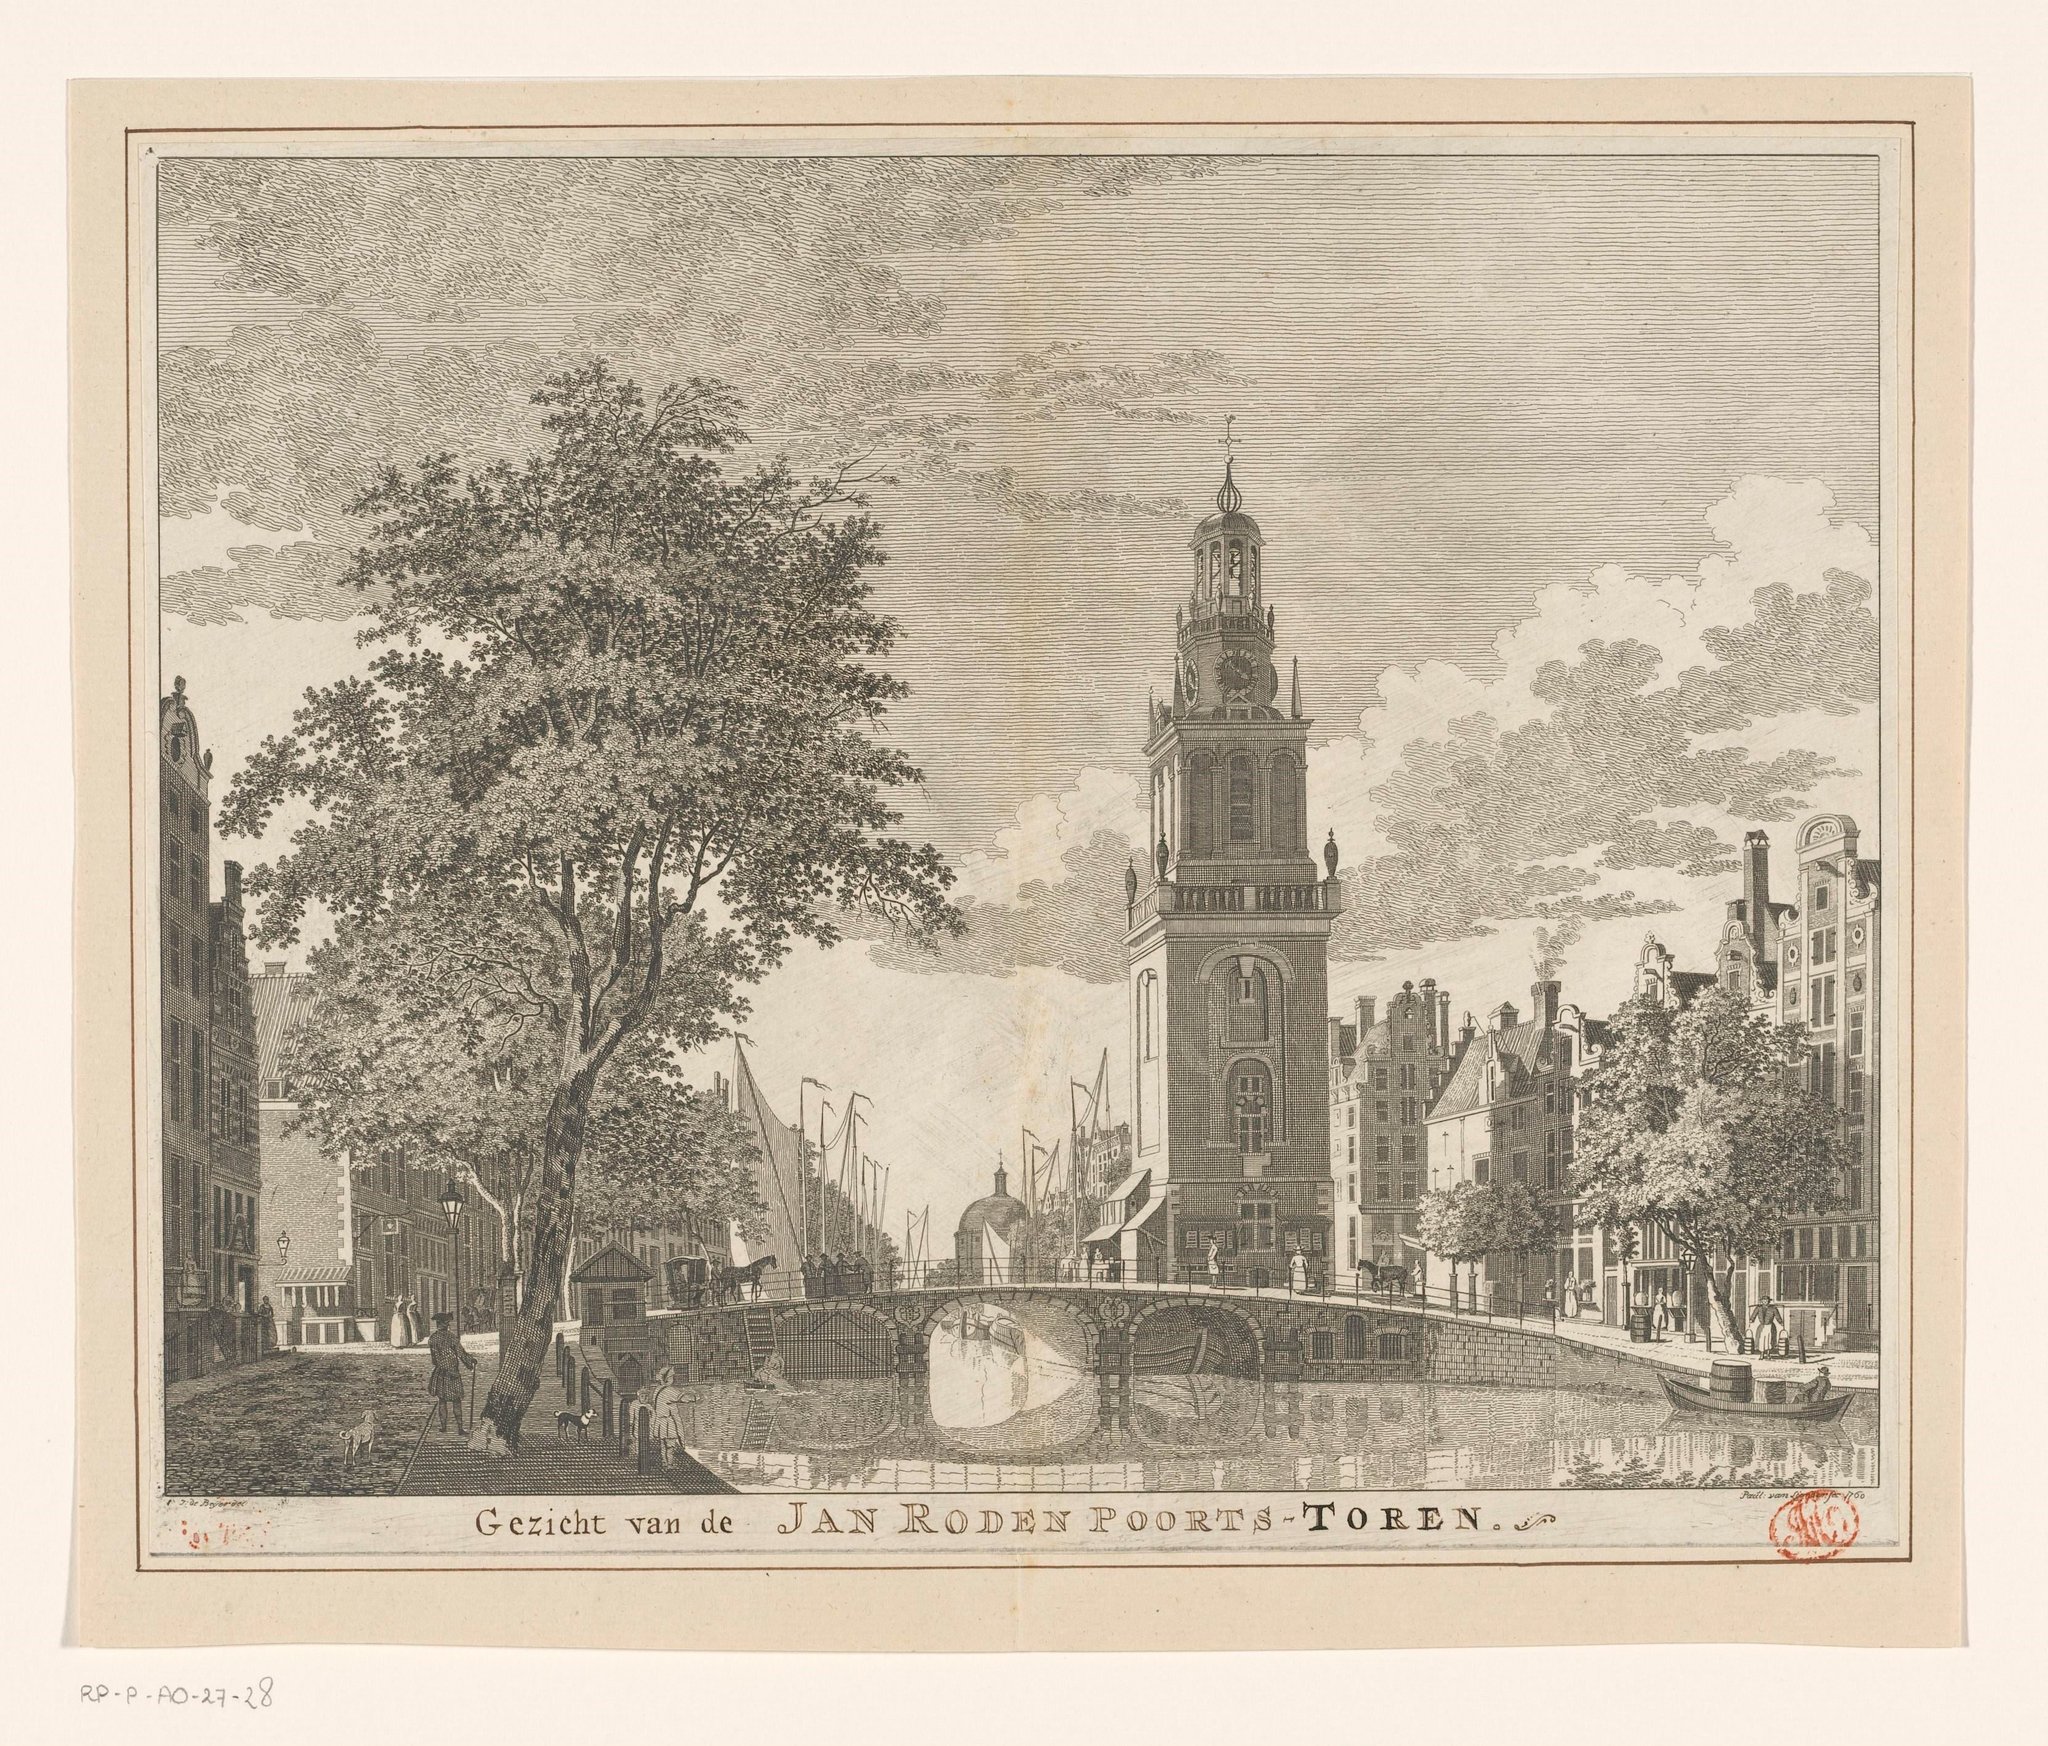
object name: print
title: Gezicht van de Jan Roden Poorts-Toren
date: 1760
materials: ink, paper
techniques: etching, pen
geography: amsterdam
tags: bridge in city across river, canal, etc. (+ city(-scape) with figures, staffage), tower, clock tower ~ monumental adornment, canals, waters (in city) (+ city(-scape) with figures, staffage), street (+ city(-scape) with figures, staffage)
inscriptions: collector's mark: Lugt 195, inscription: ‘Gezicht van de Jan Roden Poorts-Toren’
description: Latere staat opgenomen in: Nieuwe atlas, van de voornaamste gebouwen en gezigten der stad Amsterdam, met derzelver beknopte beschryvingen, 2 dln. Amsterdam: Daniel Jean Changuion en Petrus van Hengst, 1783.Latere staten van deze prent zijn ook gebruikt in de zogenaamde Atlas van Fouquet.* Pierre Fouquet gaf vanaf 1760 stadsgezichten van Amsterdam - naar tekeningen van verschillende kunstenaars, gemaakt door verschillende prentmakers - uit. Deze prenten werden aanvankelijk los of in series verkocht. Zoals toen gebruikelijk kon de koper de prenten zelf laten inbinden. Hiertoe gaf Fouquet tussen 1778 en 1783 een titelblad, plattegrond en inhoudsopgave van de tot dusver 100 uitgegeven prenten uit (1). Gezien de inhoud afhankelijk was van wat de koper had verzameld verschilt de inhoud van de verschillende bewaarde Fouquetatlassen onder deze titel sterk. Ook zijn er exemplaren bekend waar tevens andere prenten aan zijn toegevoegd. Omdat er behoefte bleek aan uitleg bij de platen werd in 1783 een nieuwe versie van de atlas uitgegeven, aangevuld met tekst en twee prenten. De aangegeven volgorde veranderde maar de platen van de al eerder uitgegeven prenten bleven ongewijzigd. Deze uitgave werd in opdracht van Fouquet gedrukt bij Daniël Jean Changuion en Petrus den Hengst (2). Een tiental platen werd bijgewerkt en verscheen, met nieuw impressum, in het vervolg van Wagenaars geschiedenis van Amsterdam, uitgeven door Petrus Conradi en Folkert van der Plaats (3). Een aantal jaar na het overlijden van Fouquet kwam Evert Maaskamp met een nieuwe uitgave van de atlas, met verbeterde tekst en toevoeging van twee prenten. Op alle platen verwijderde hij het oude en liet hij zijn eigen impressum zetten (4). * Onder de Atlas van Fouquet of Fouquetatlas verstaan we de hieronder vermelde publicaties (1), (2) en (4). (1). Afbeeldingen van de wyd-vermaarde koopstad Amsterdam benevens des zelvs voornaamste gebouwen en gezigten alle naar het leeven getekend / Receuil des edifices les plus considerables et des plus belles vues, de la fameuse ville d'Amsterdam, dessinées d'après nature. Amsterdam: Pierre Fouquet, 1778-1783. (2). Nieuwe atlas, van de voornaamste gebouwen en gezigten der stad Amsterdam, met derzelver beknopte beschryvingen. 2 delen. Amsterdam: Daniël Jean Changuion en Petrus den Hengst [in opdracht van Pierre Fouquet], 1783. (3). Stijl, Simon. Amsterdam, in zyne geschiedenissen, voorregten, koophandel, gebouwen, kerkenstaat, schoolen, schutterye, gilden en regeeringe, beschreeven. Om te dienen ten vervolge op het werk van Jan Wagenaar (…). 10 delen. Amsterdam en Harlingen: Petrus Conradi en Folkert van der Plaats, 1788-1801. (4). Nieuwe atlas, van de voornaamste gebouwen en gezigten der stad Amsterdam. Met derzelver beknopte beschryvingen. Amsterdam: Evert Maaskamp, 1805. * Het aantal vermelde staten is gebaseerd op het aantal gevonden staten. Mogelijk zijn er meer staten van deze prent. Zie ook RP-P-1911-3090 voor eerste bekende staat. Zie RP-P-1911-3089 voor tweede bekende staat. Zie RP-P-OB-46.357 voor derde bekende staat.